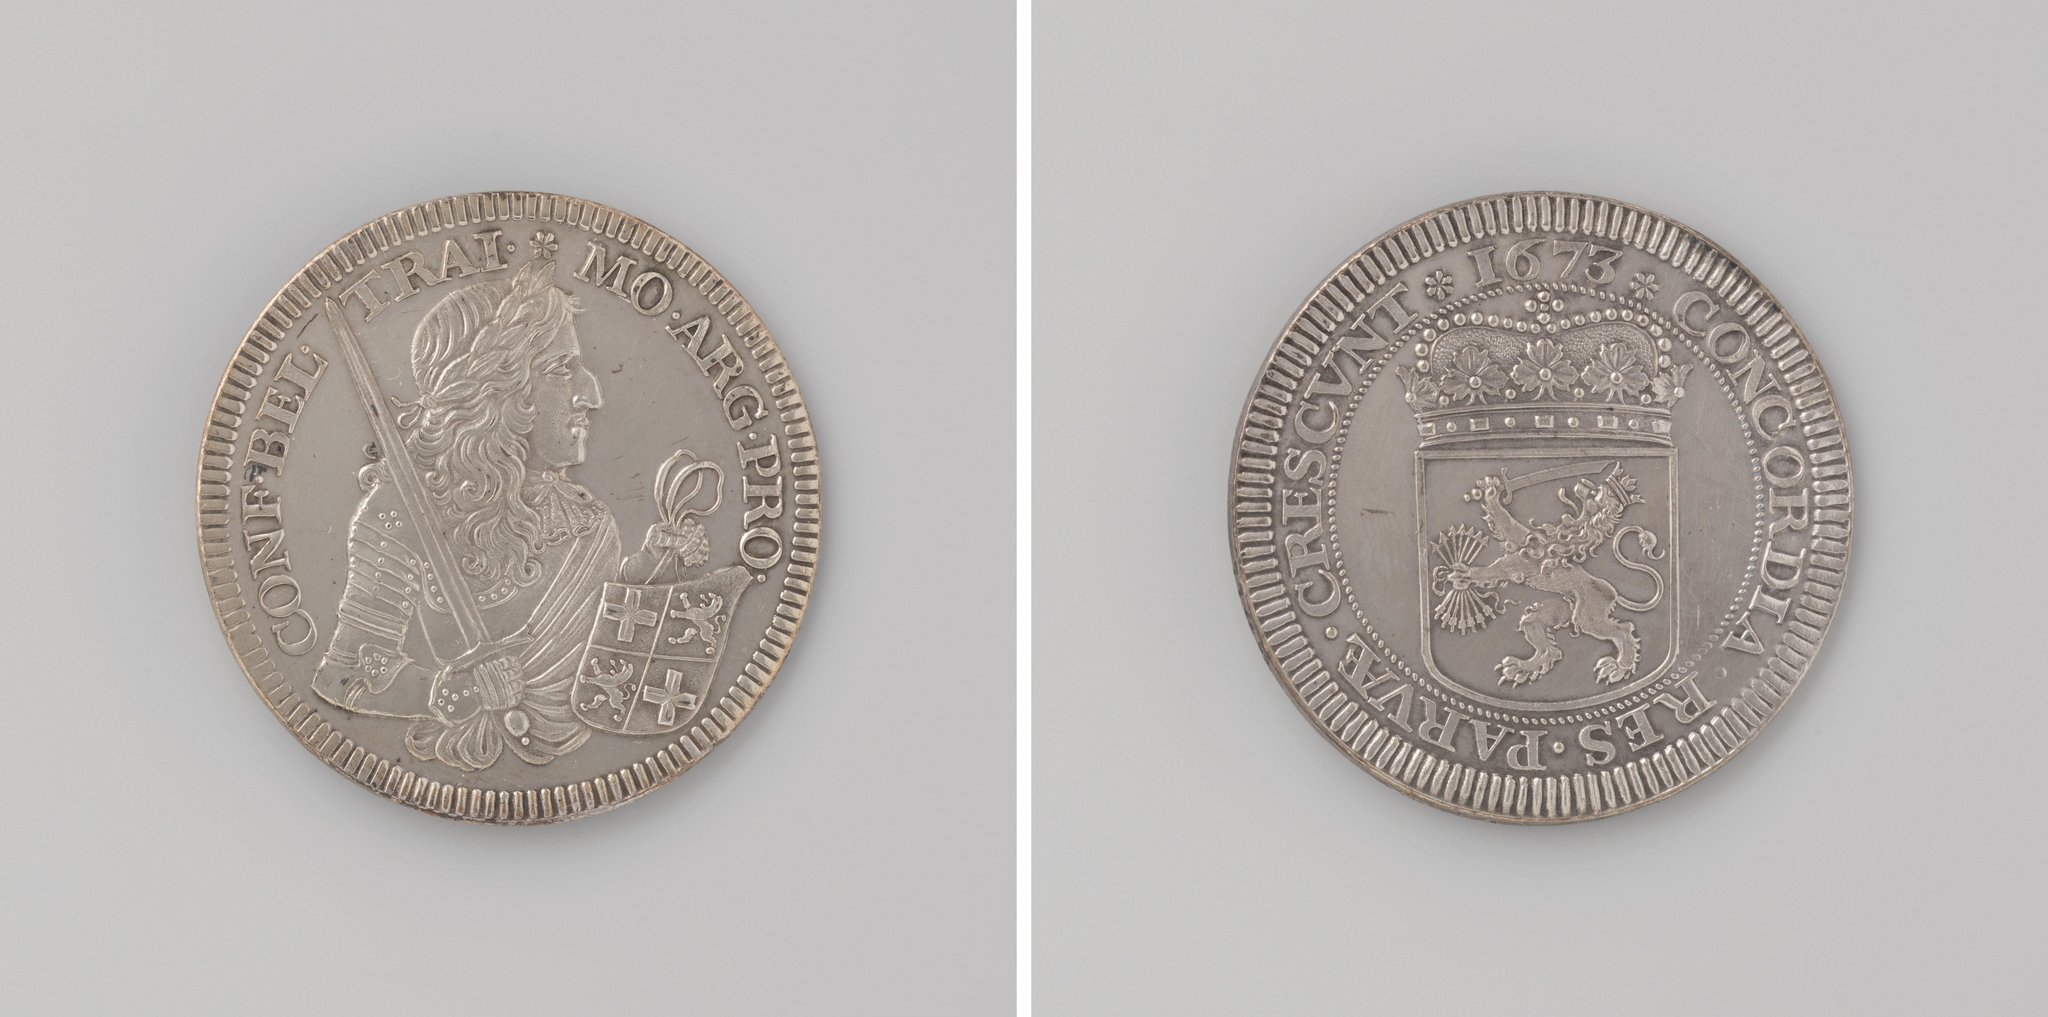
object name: reichsthaler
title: Willem III, prins van Oranje-Nassau, proefslag van een rijksdaalder, geslagen nadat de Fransen de stad verlaten hadden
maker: dirk bosch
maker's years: 1621-1680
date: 1673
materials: silver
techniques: striking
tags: the hague, william iii (prince of orange and king of england, scotland, and ireland), utrecht, amsterdam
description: Zilveren penning. Voorzijde: borststuk man met lauwerkrans met in handen zwaard en wapenschild binnen omschrift. Keerzijde: gekroond wapenschild binnen omschrift.